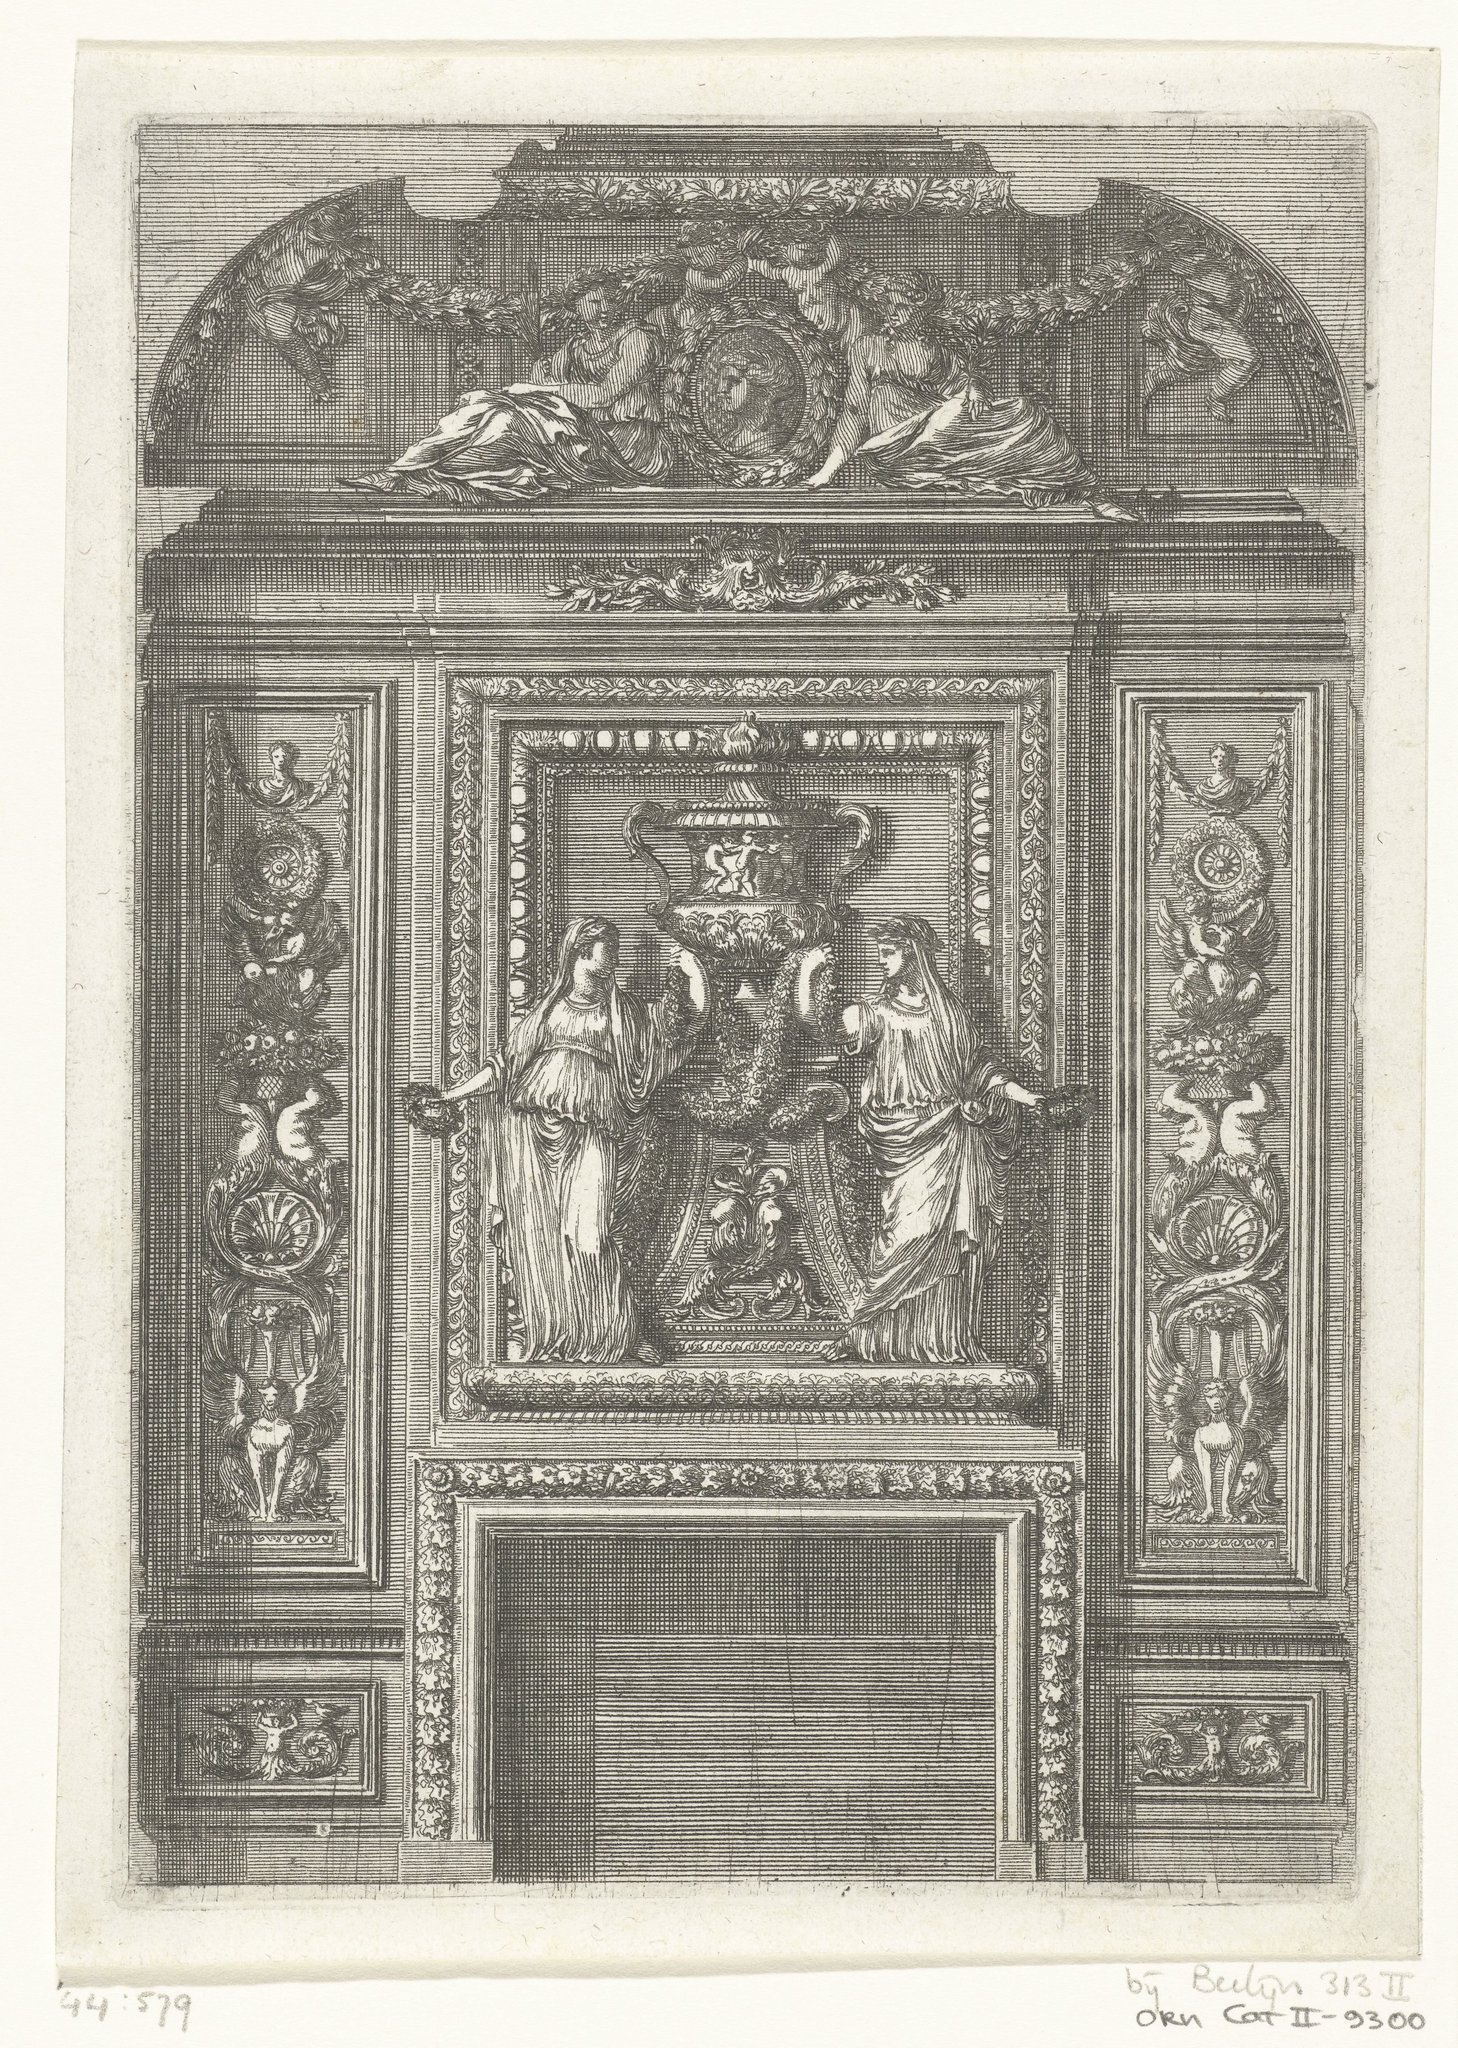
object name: print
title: Onderboezems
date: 1651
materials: paper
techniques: etching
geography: france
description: In het midden staat een voetstuk met een urn. Uit serie van 12 bladen.